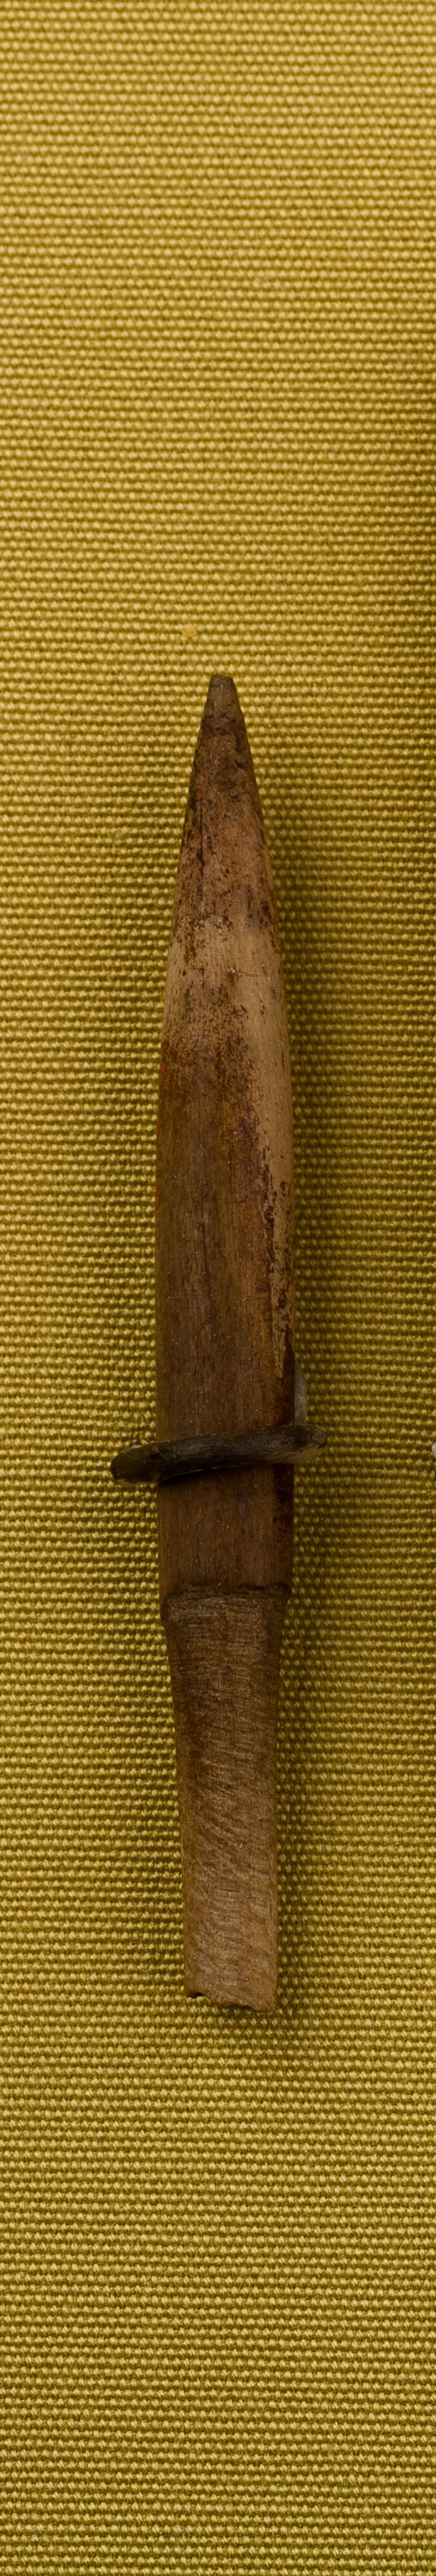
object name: arrowhead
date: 3100-2900 BCE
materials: ivory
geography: egypt